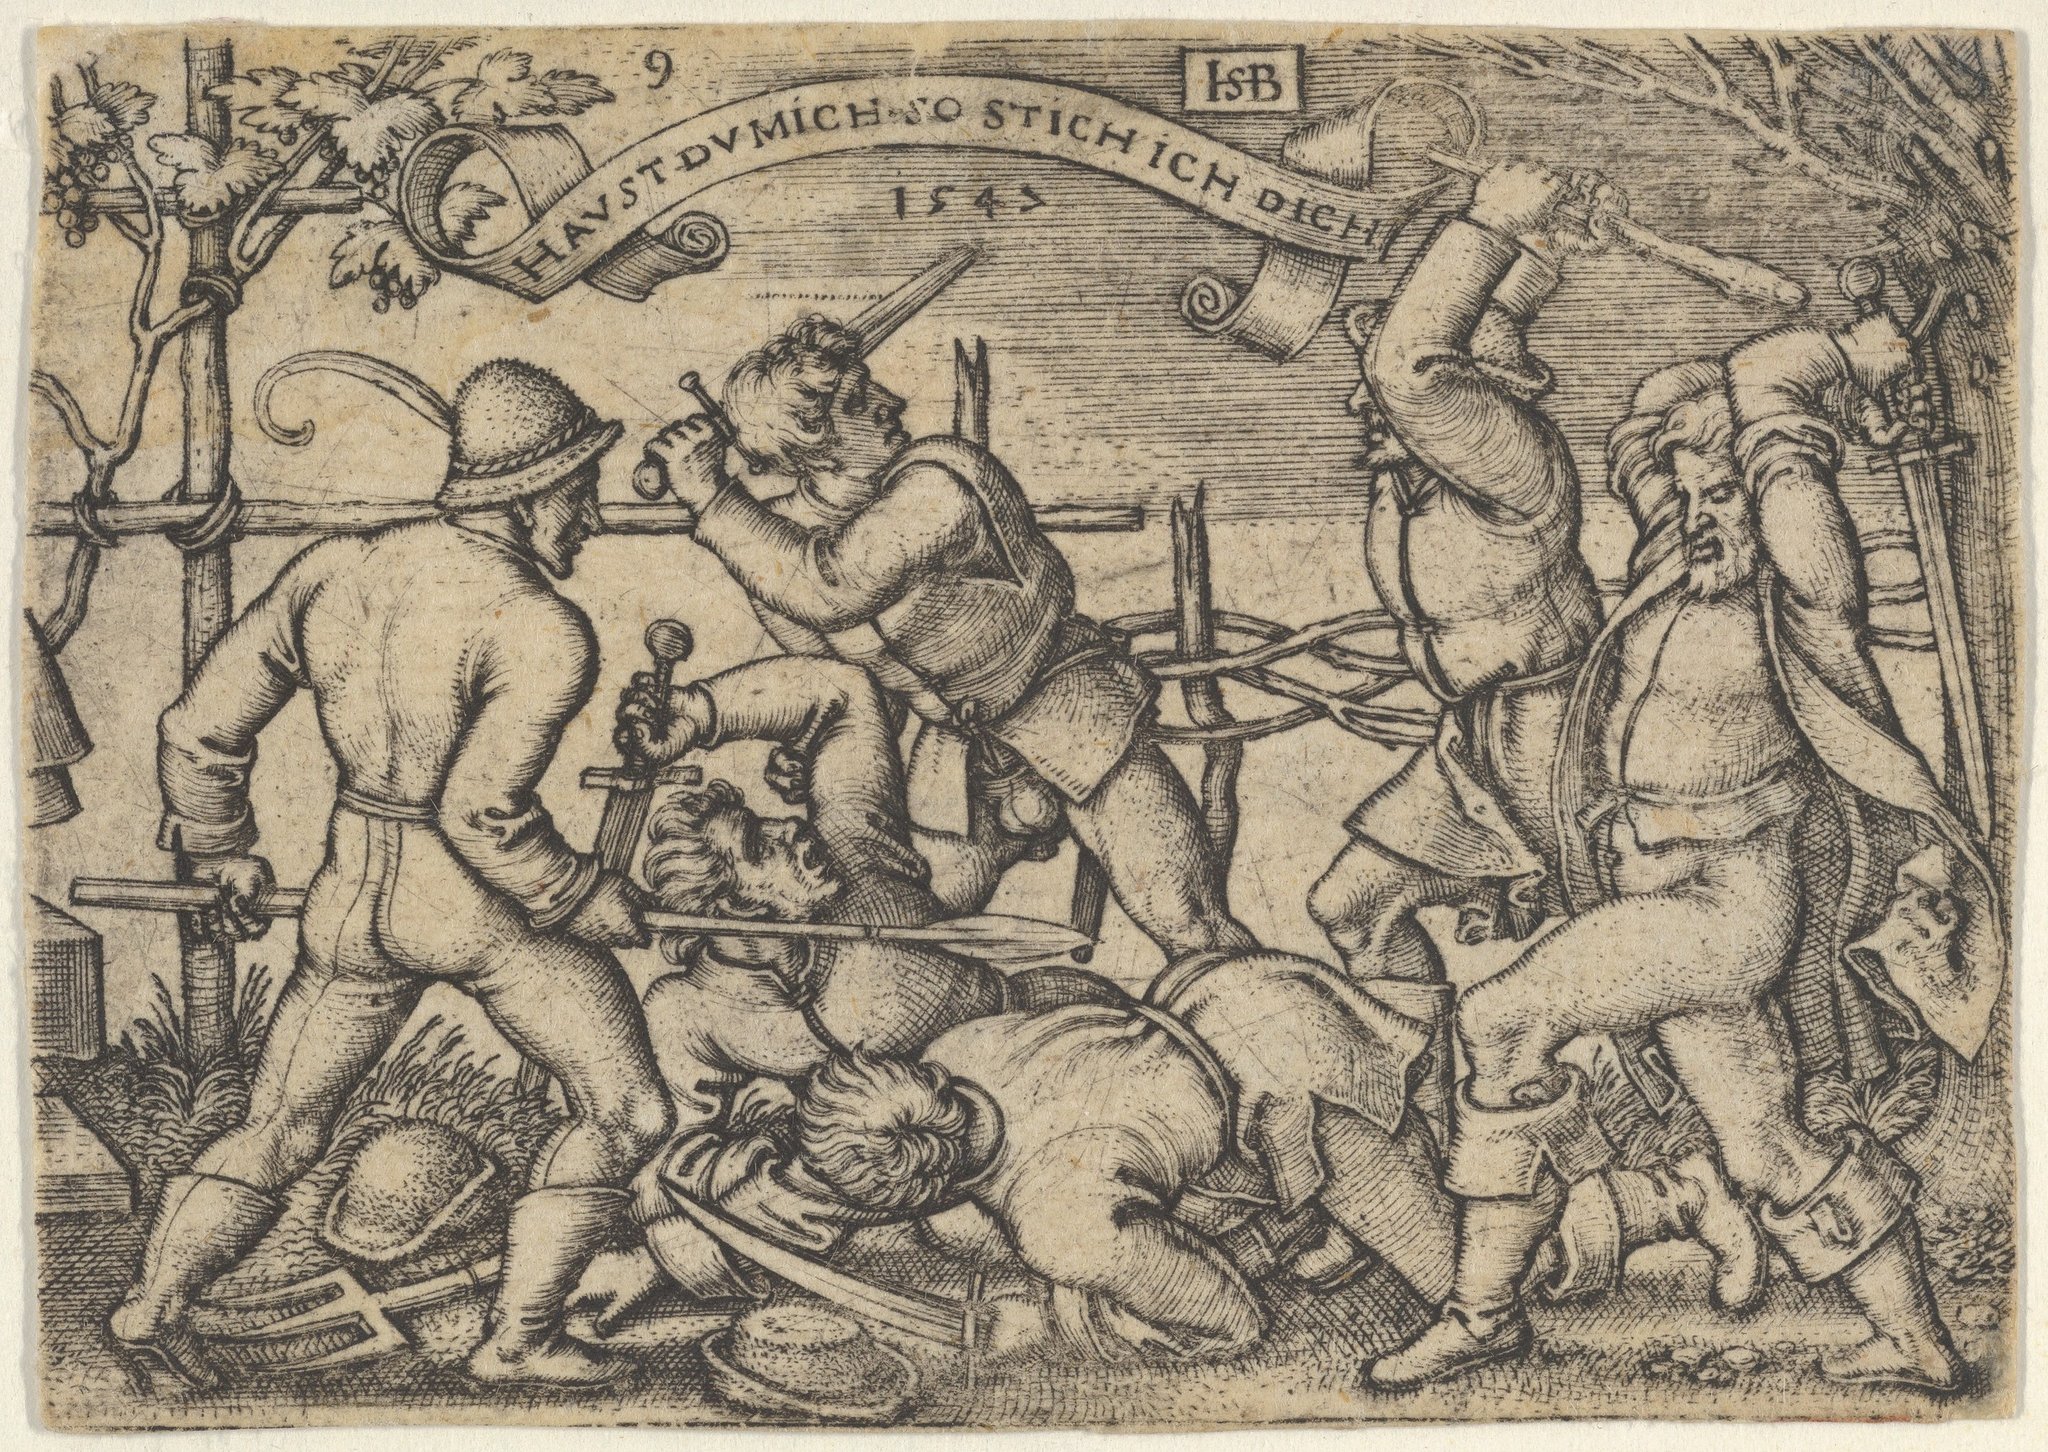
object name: print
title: Peasants' Brawl from The Peasants' Feast or the Twelve Months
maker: sebald beham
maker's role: artist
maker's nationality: german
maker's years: 1500-1550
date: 1547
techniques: engraving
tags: battles,men